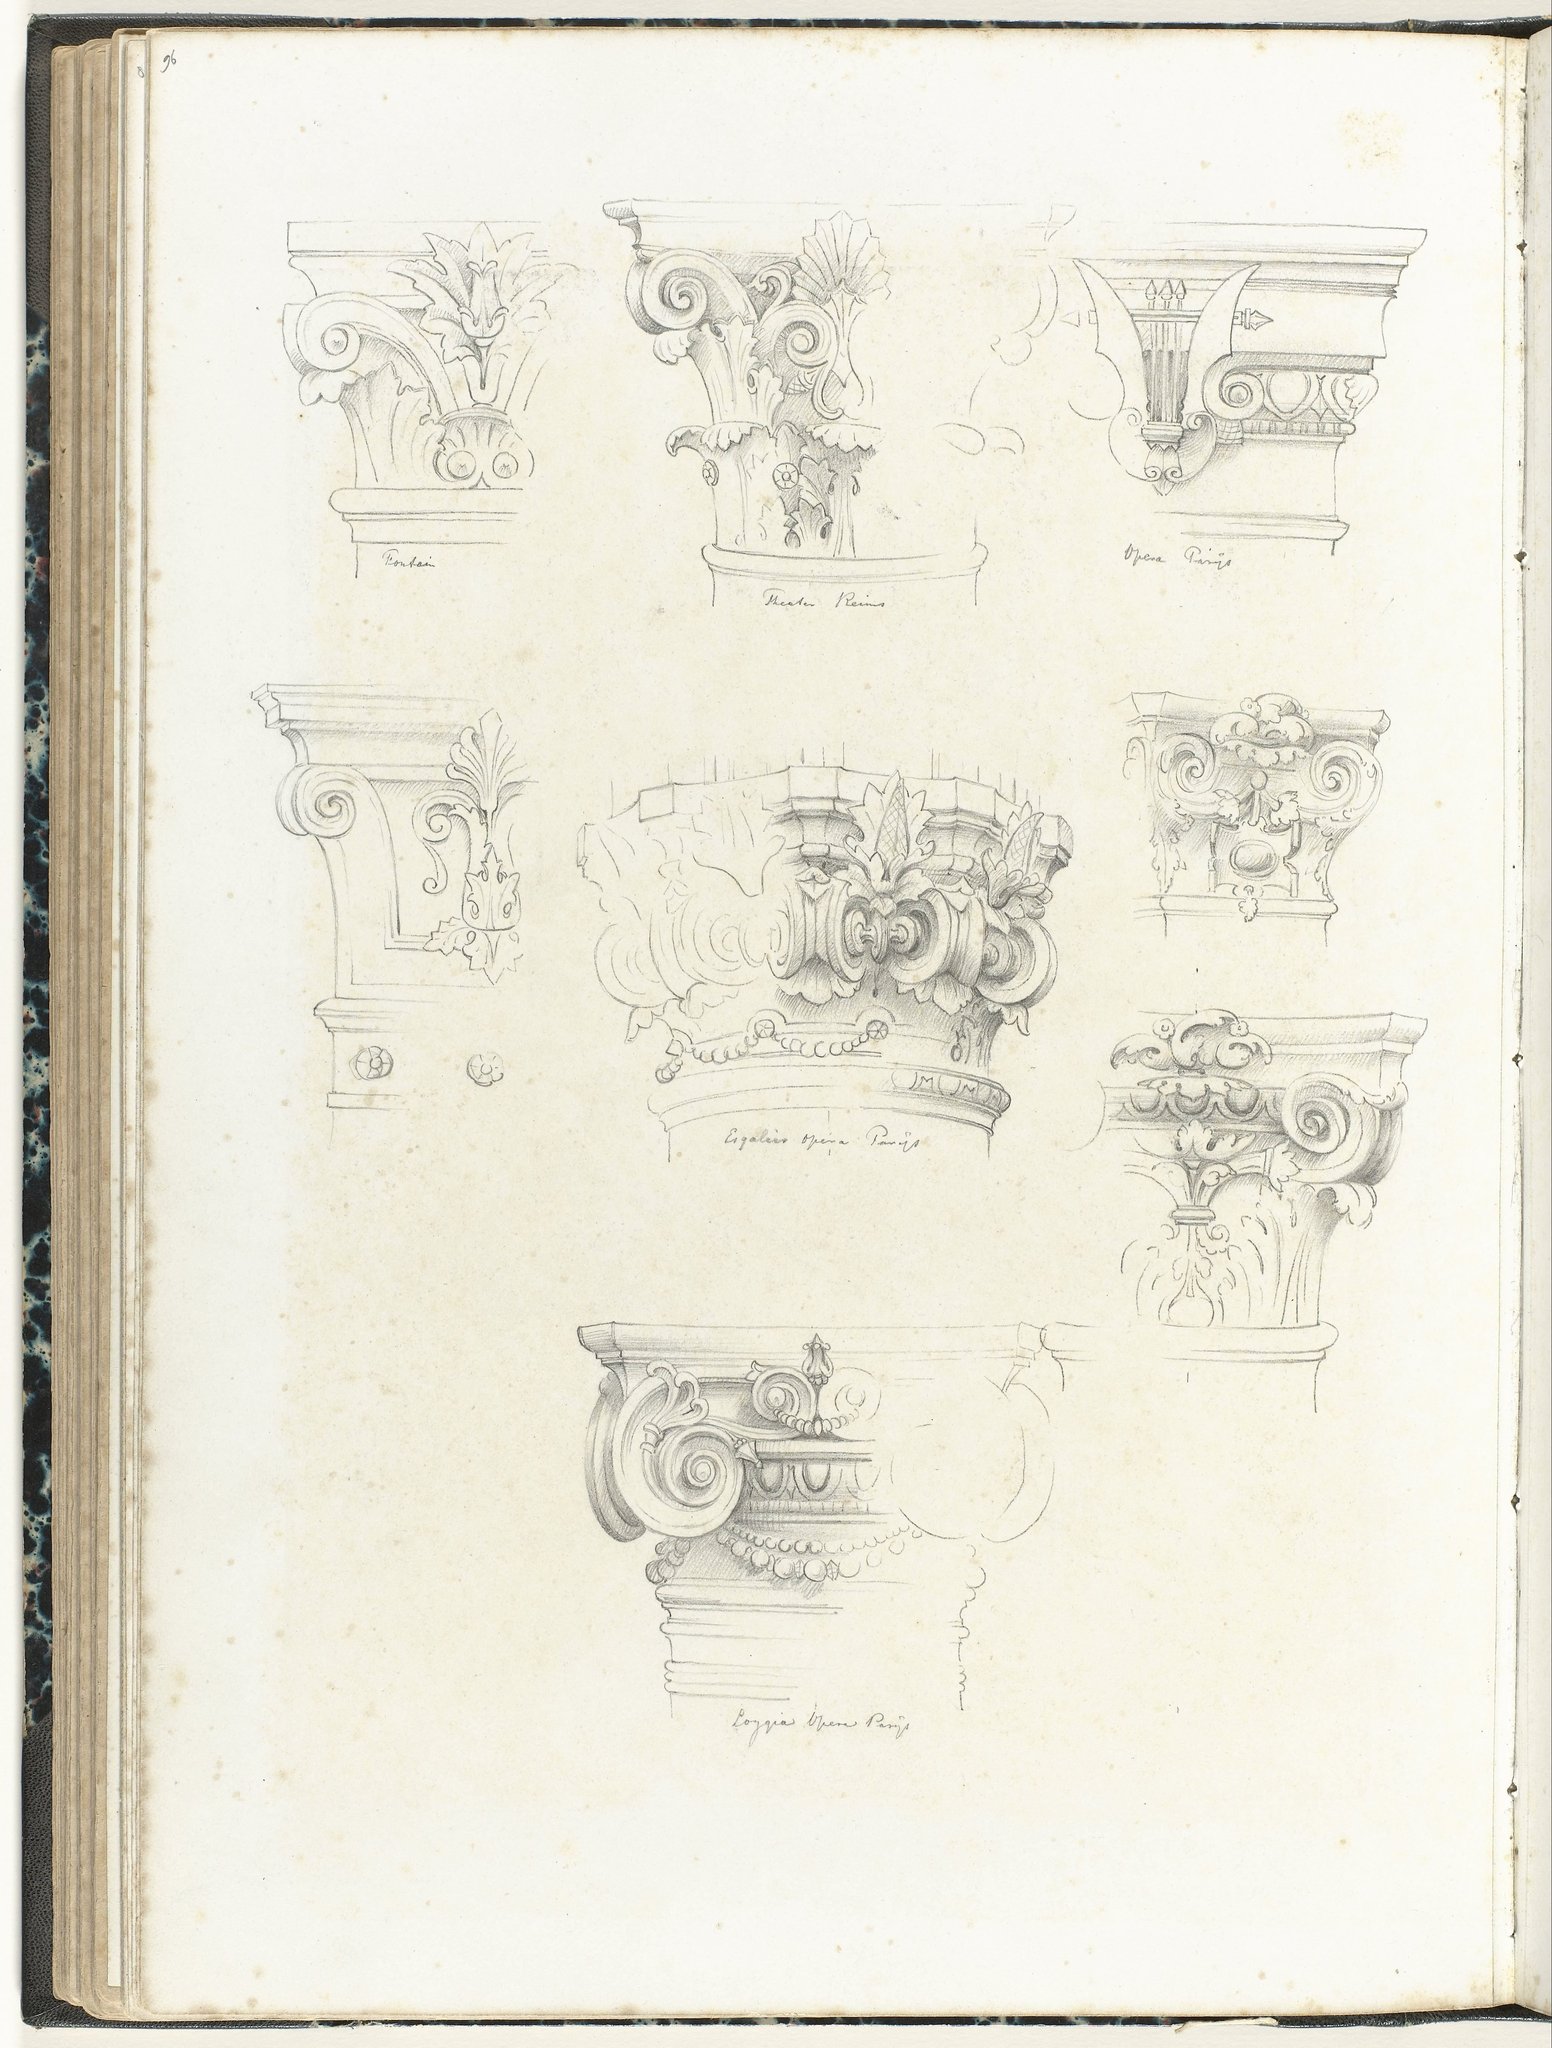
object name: drawing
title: Acht kapitelen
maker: Anonymous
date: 1866-1900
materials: paper, pencil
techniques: drawing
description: Onder een aantal kapitelen staat vermeld tot welk bouwwerk ze behoren.